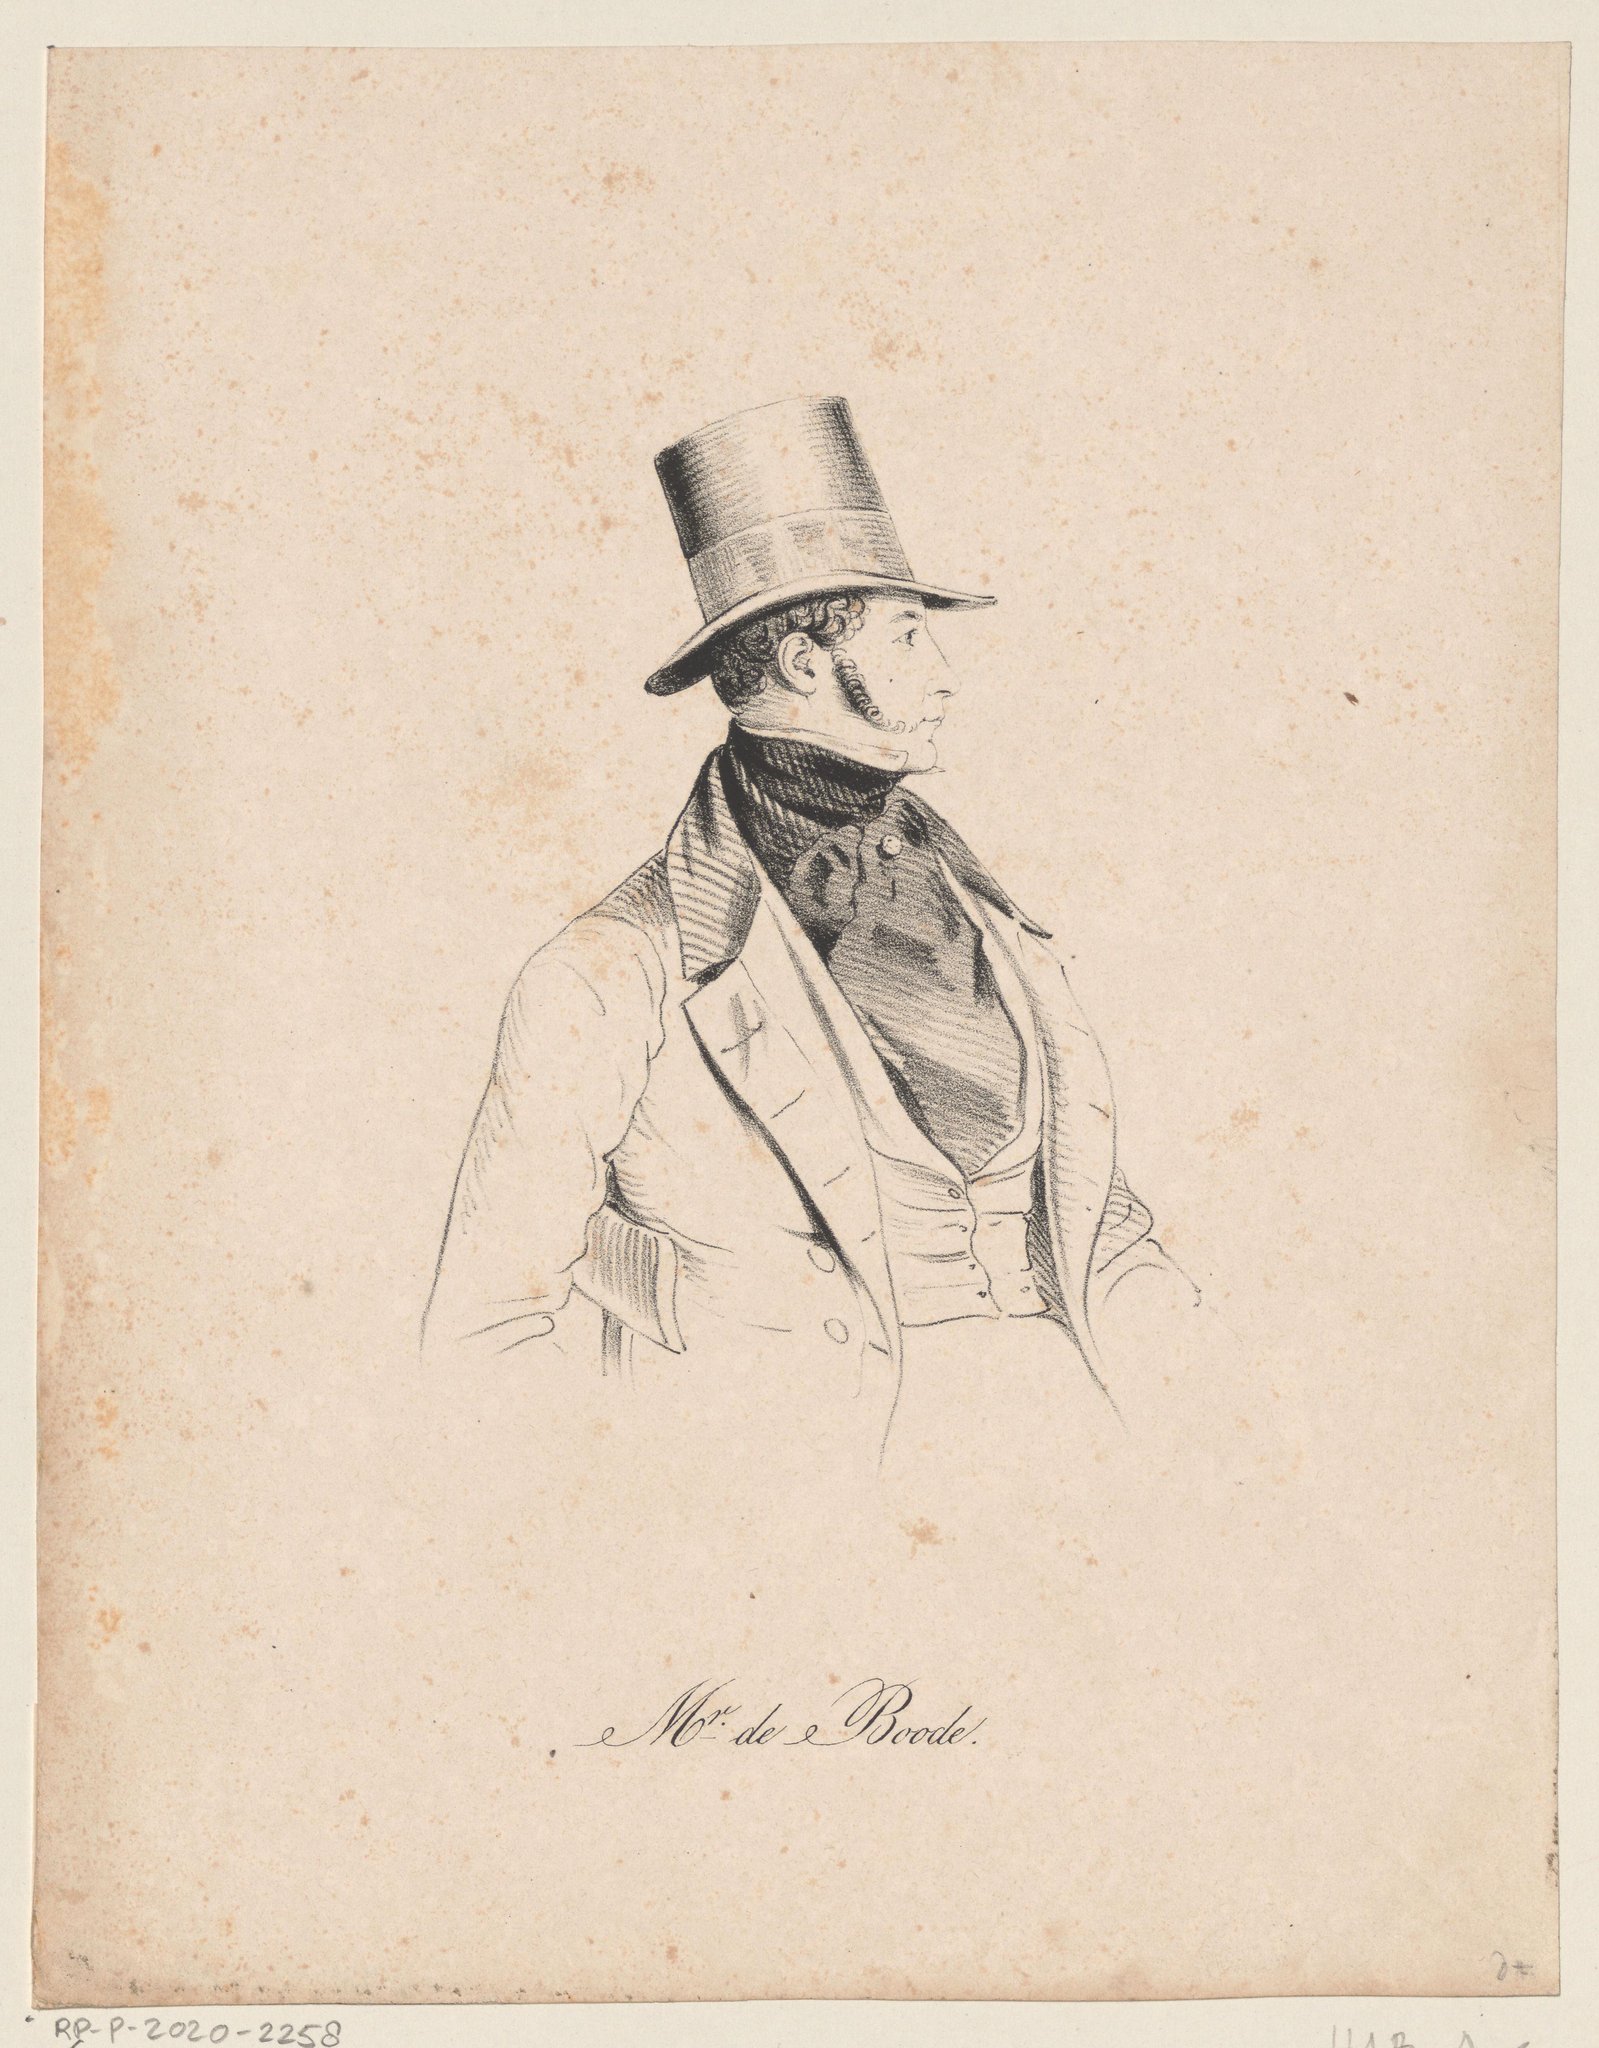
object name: print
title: Portret van meneer De Boode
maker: Anonymous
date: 1825-1875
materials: paper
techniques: lithograph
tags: historical persons